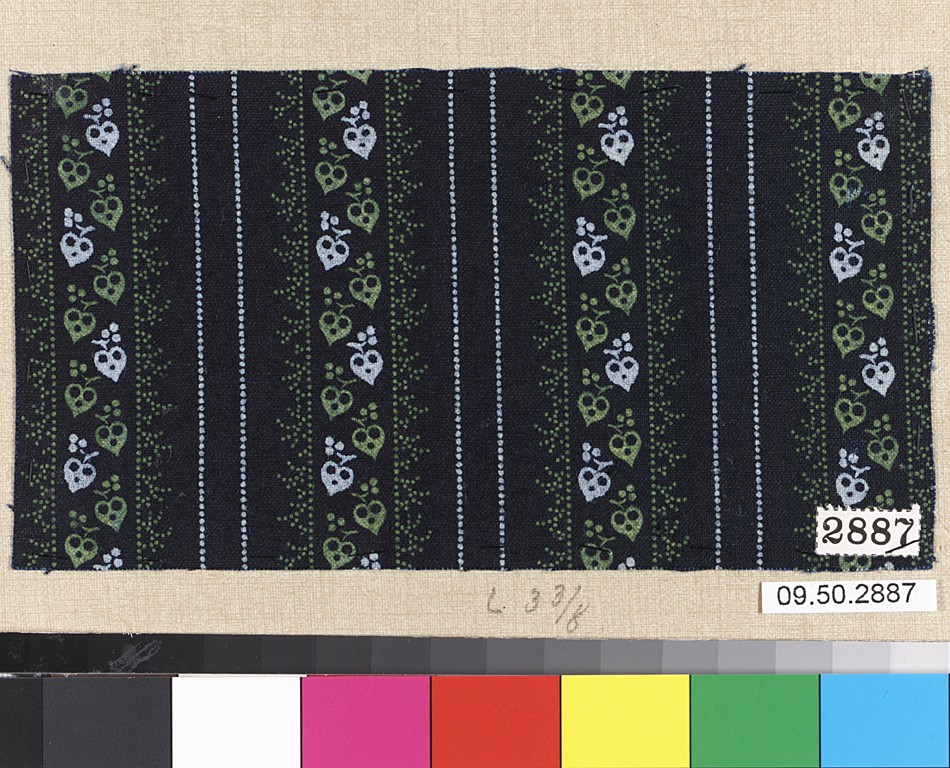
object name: piece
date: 1801-1900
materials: cotton